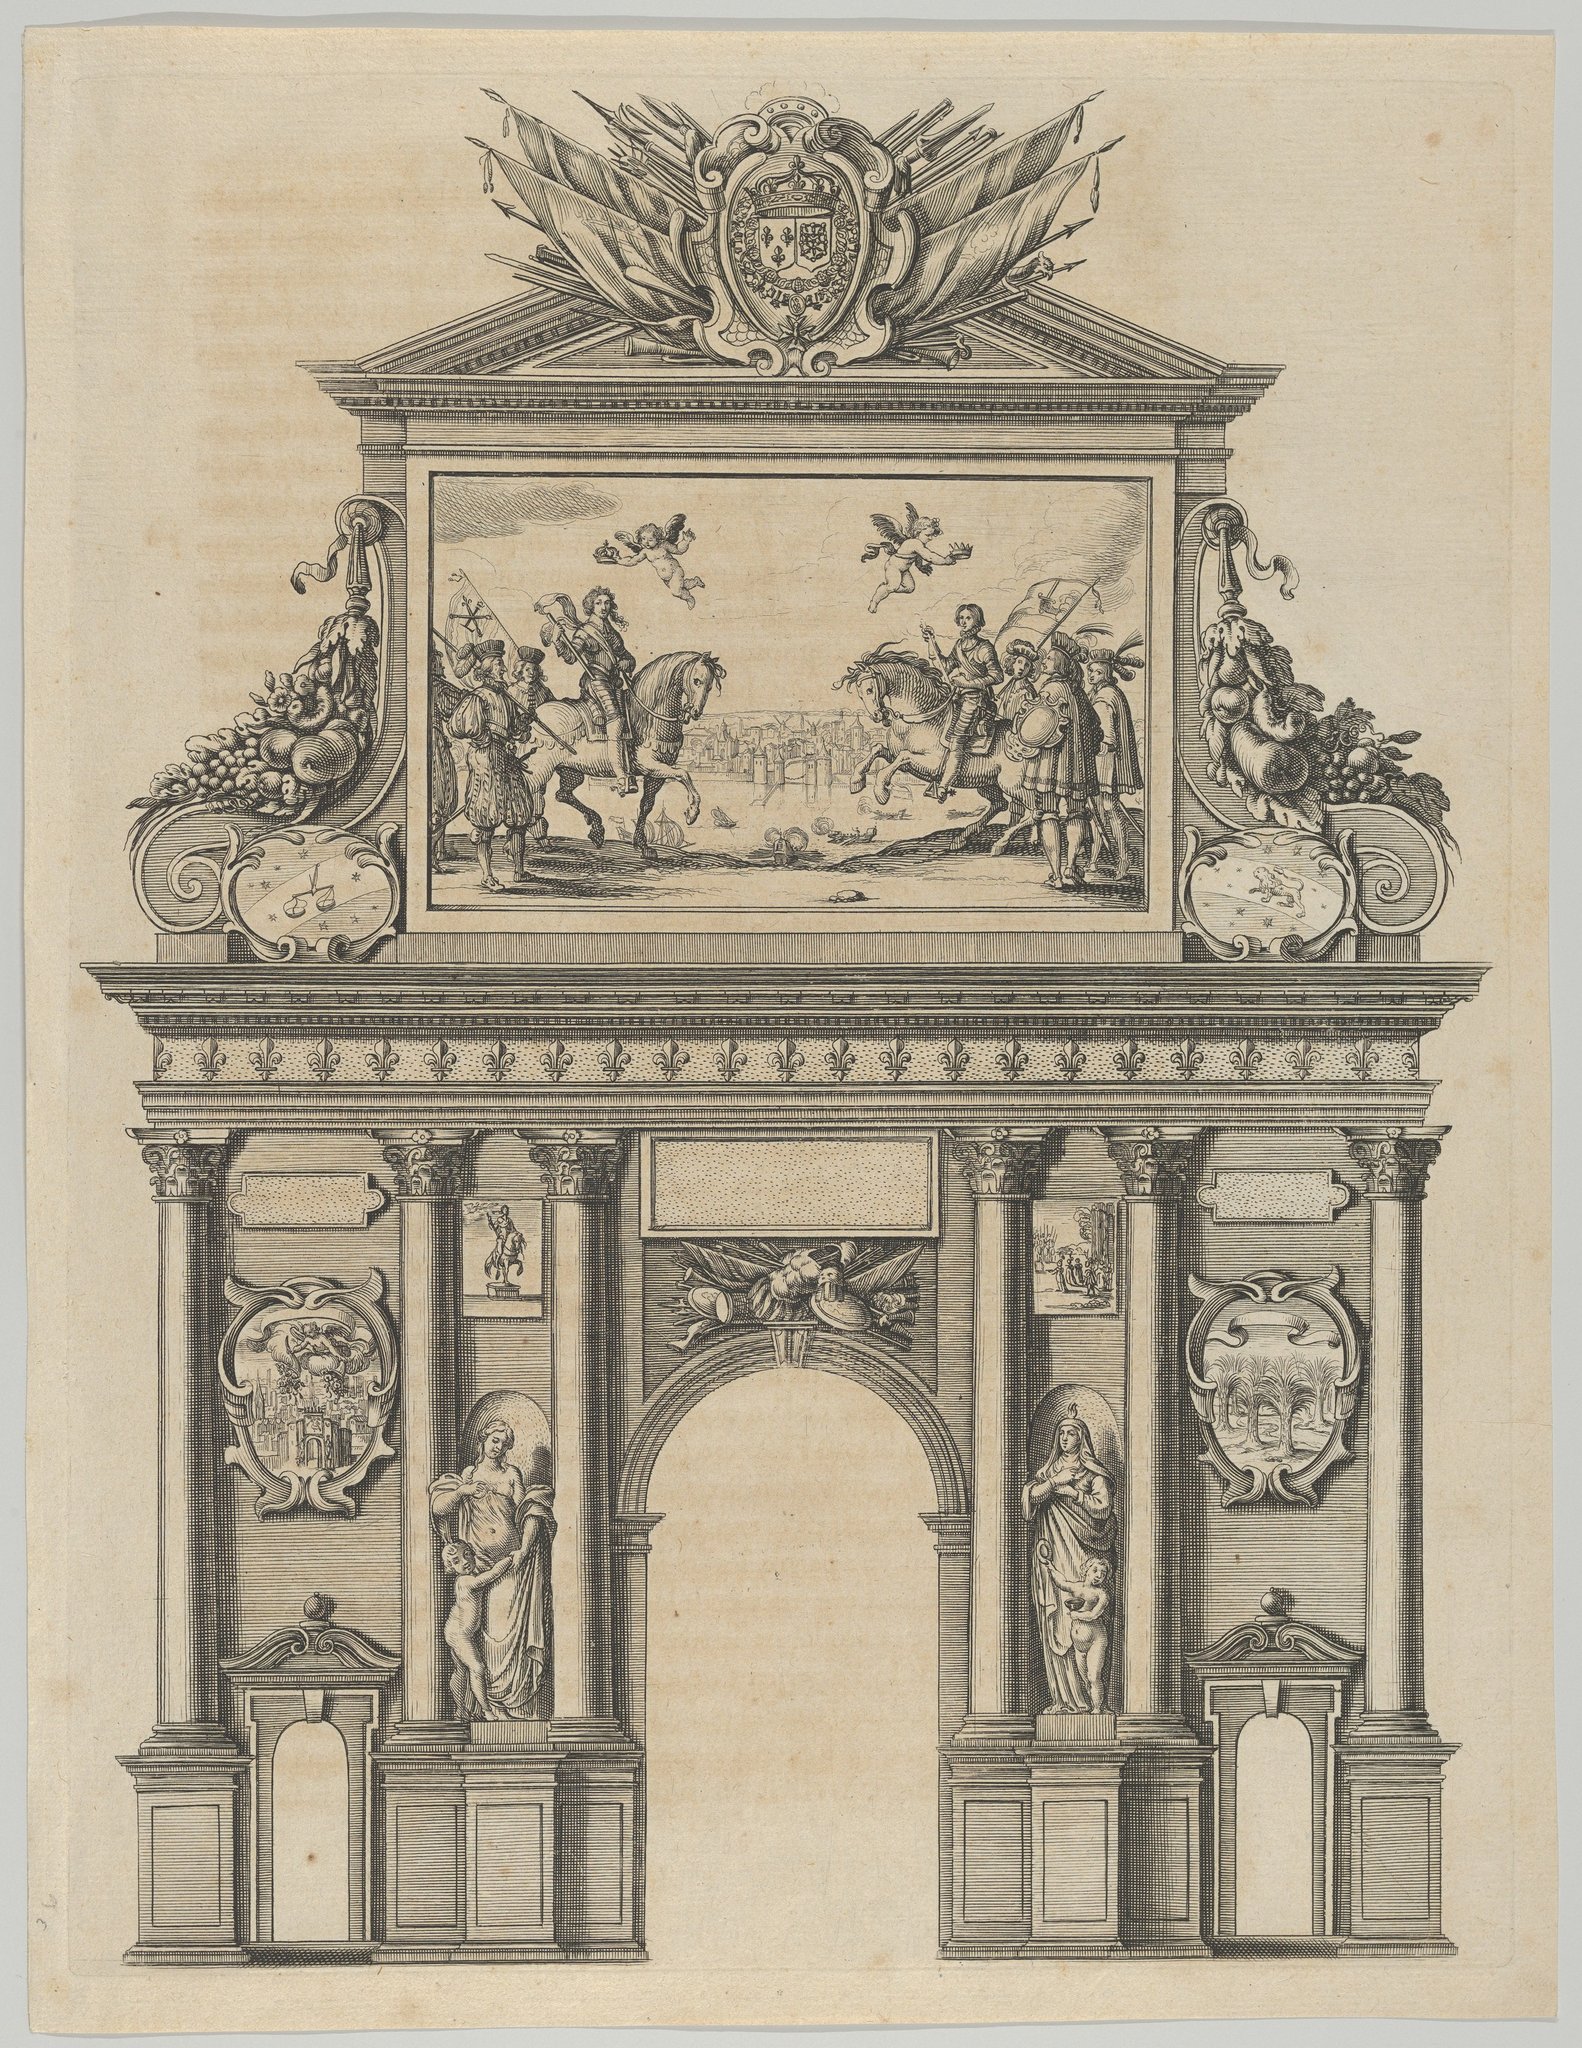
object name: print, fete, ornament architecture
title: Triumphal arch, from 'Éloges et discours sur la triomphante réception du Roy en sa ville de Paris ...' by Jean-Baptiste de Machault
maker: melchior tavernier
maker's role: artist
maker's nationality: french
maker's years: 1564-1641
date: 1629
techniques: etching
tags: arches,horses,coat of arms